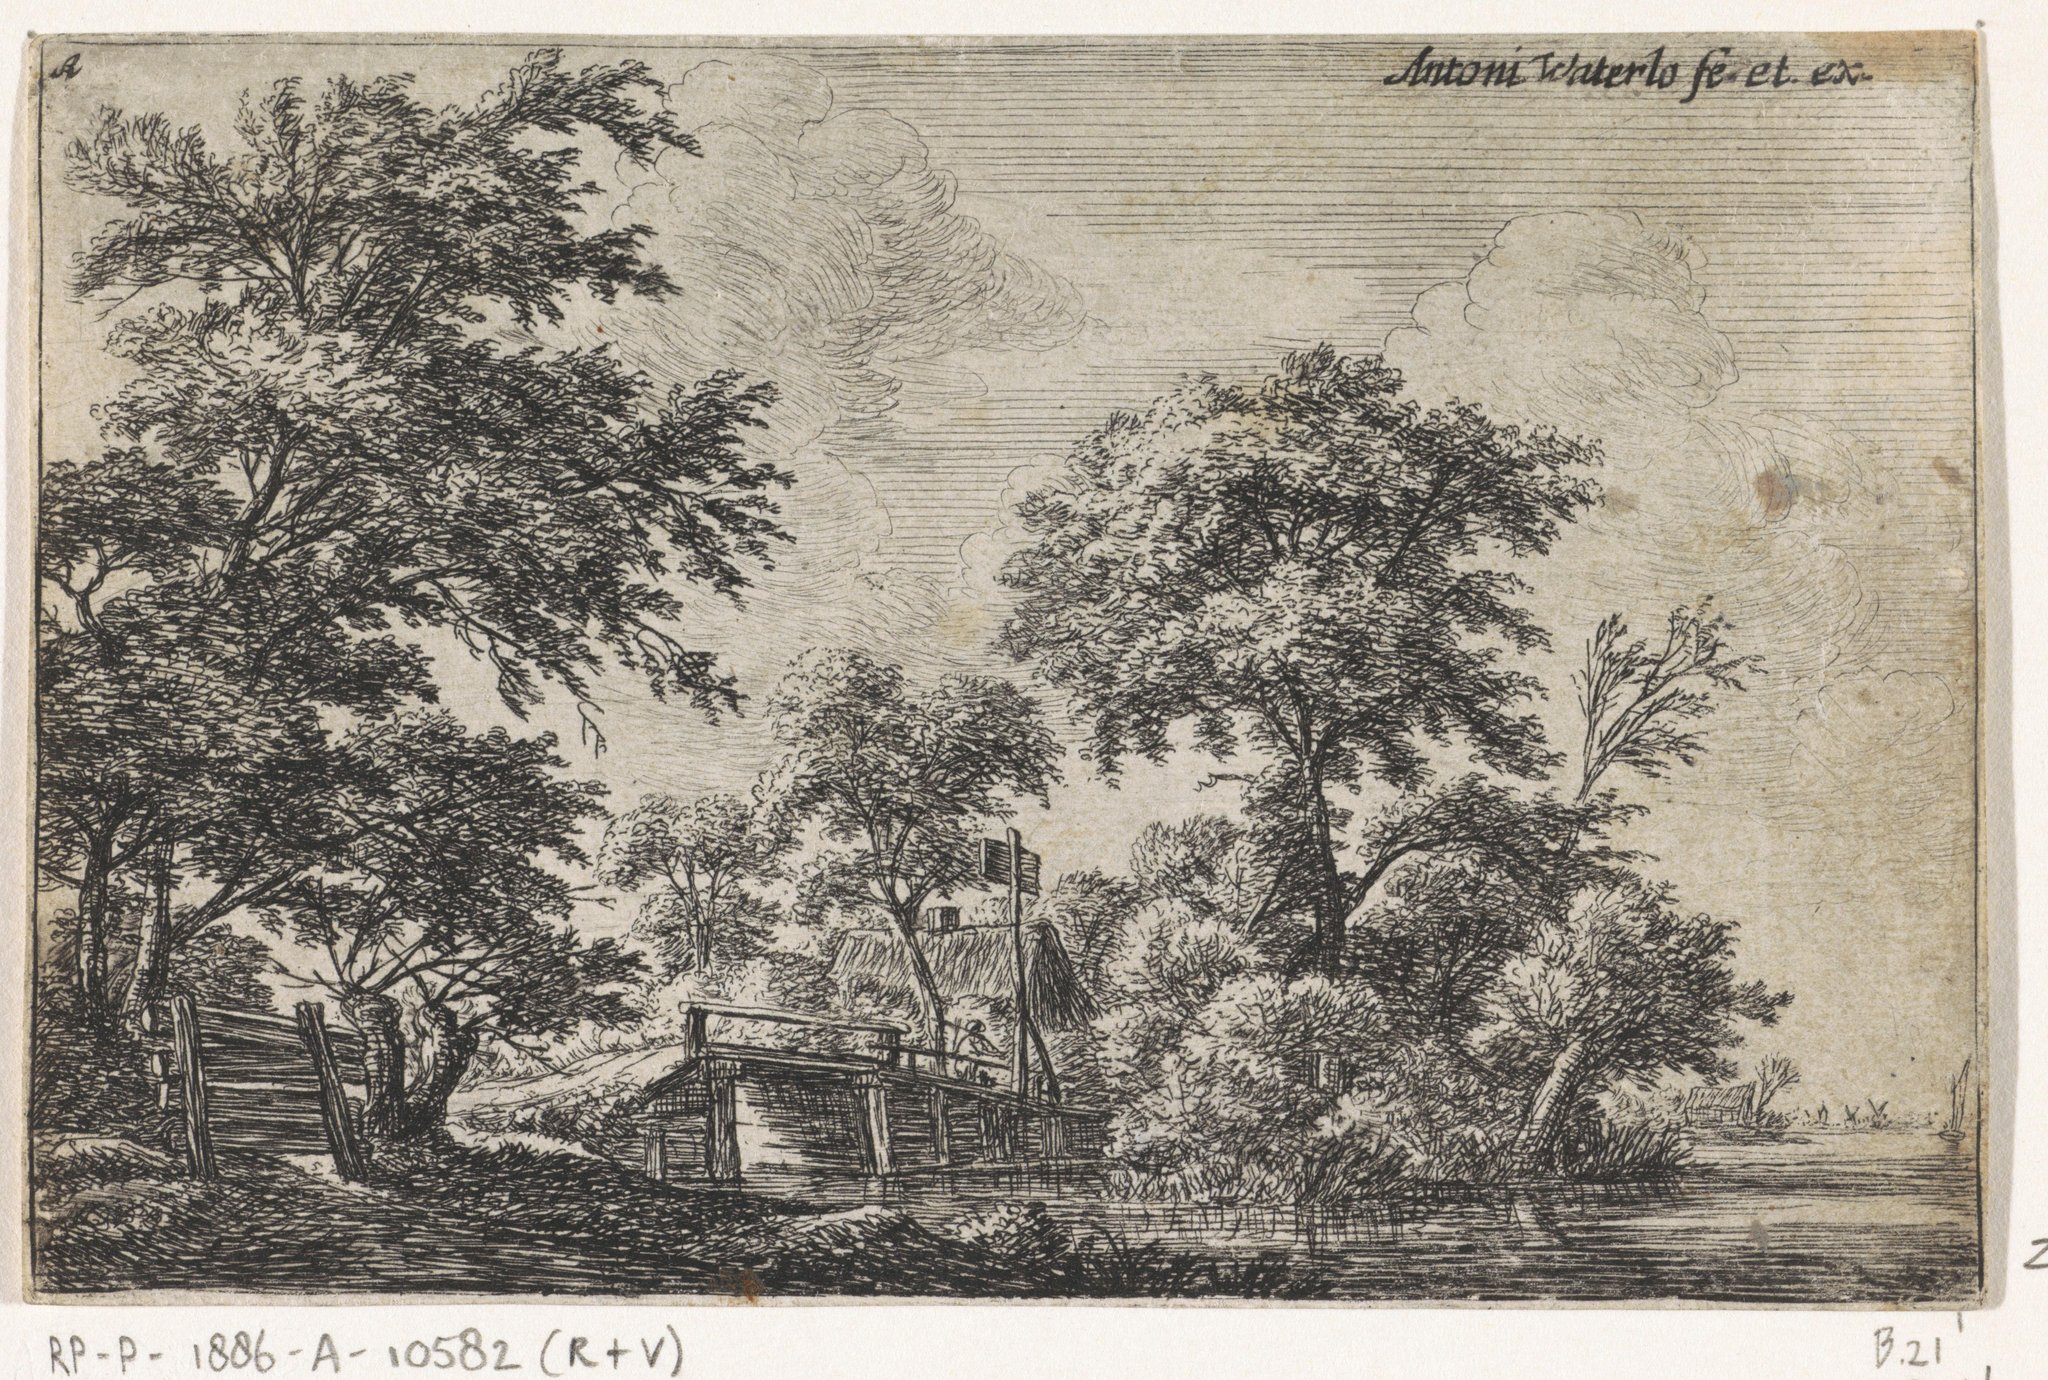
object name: print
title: Landschappen met figuren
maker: anthonie waterloo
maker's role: draughtsman, painter, print maker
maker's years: 1609-1690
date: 1630-1663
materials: paper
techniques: etching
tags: bridge, landscapes with waters, waterscapes, seascapes (in the temperate zone) (+ landscape with figures, staffage), farm or solitary house in landscape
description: Een houten brug leidt naar een door bomen omringd huis. Een houten hek geeft toegang tot de brug. Op de brug staat een figuur. Linksboven de letter A.